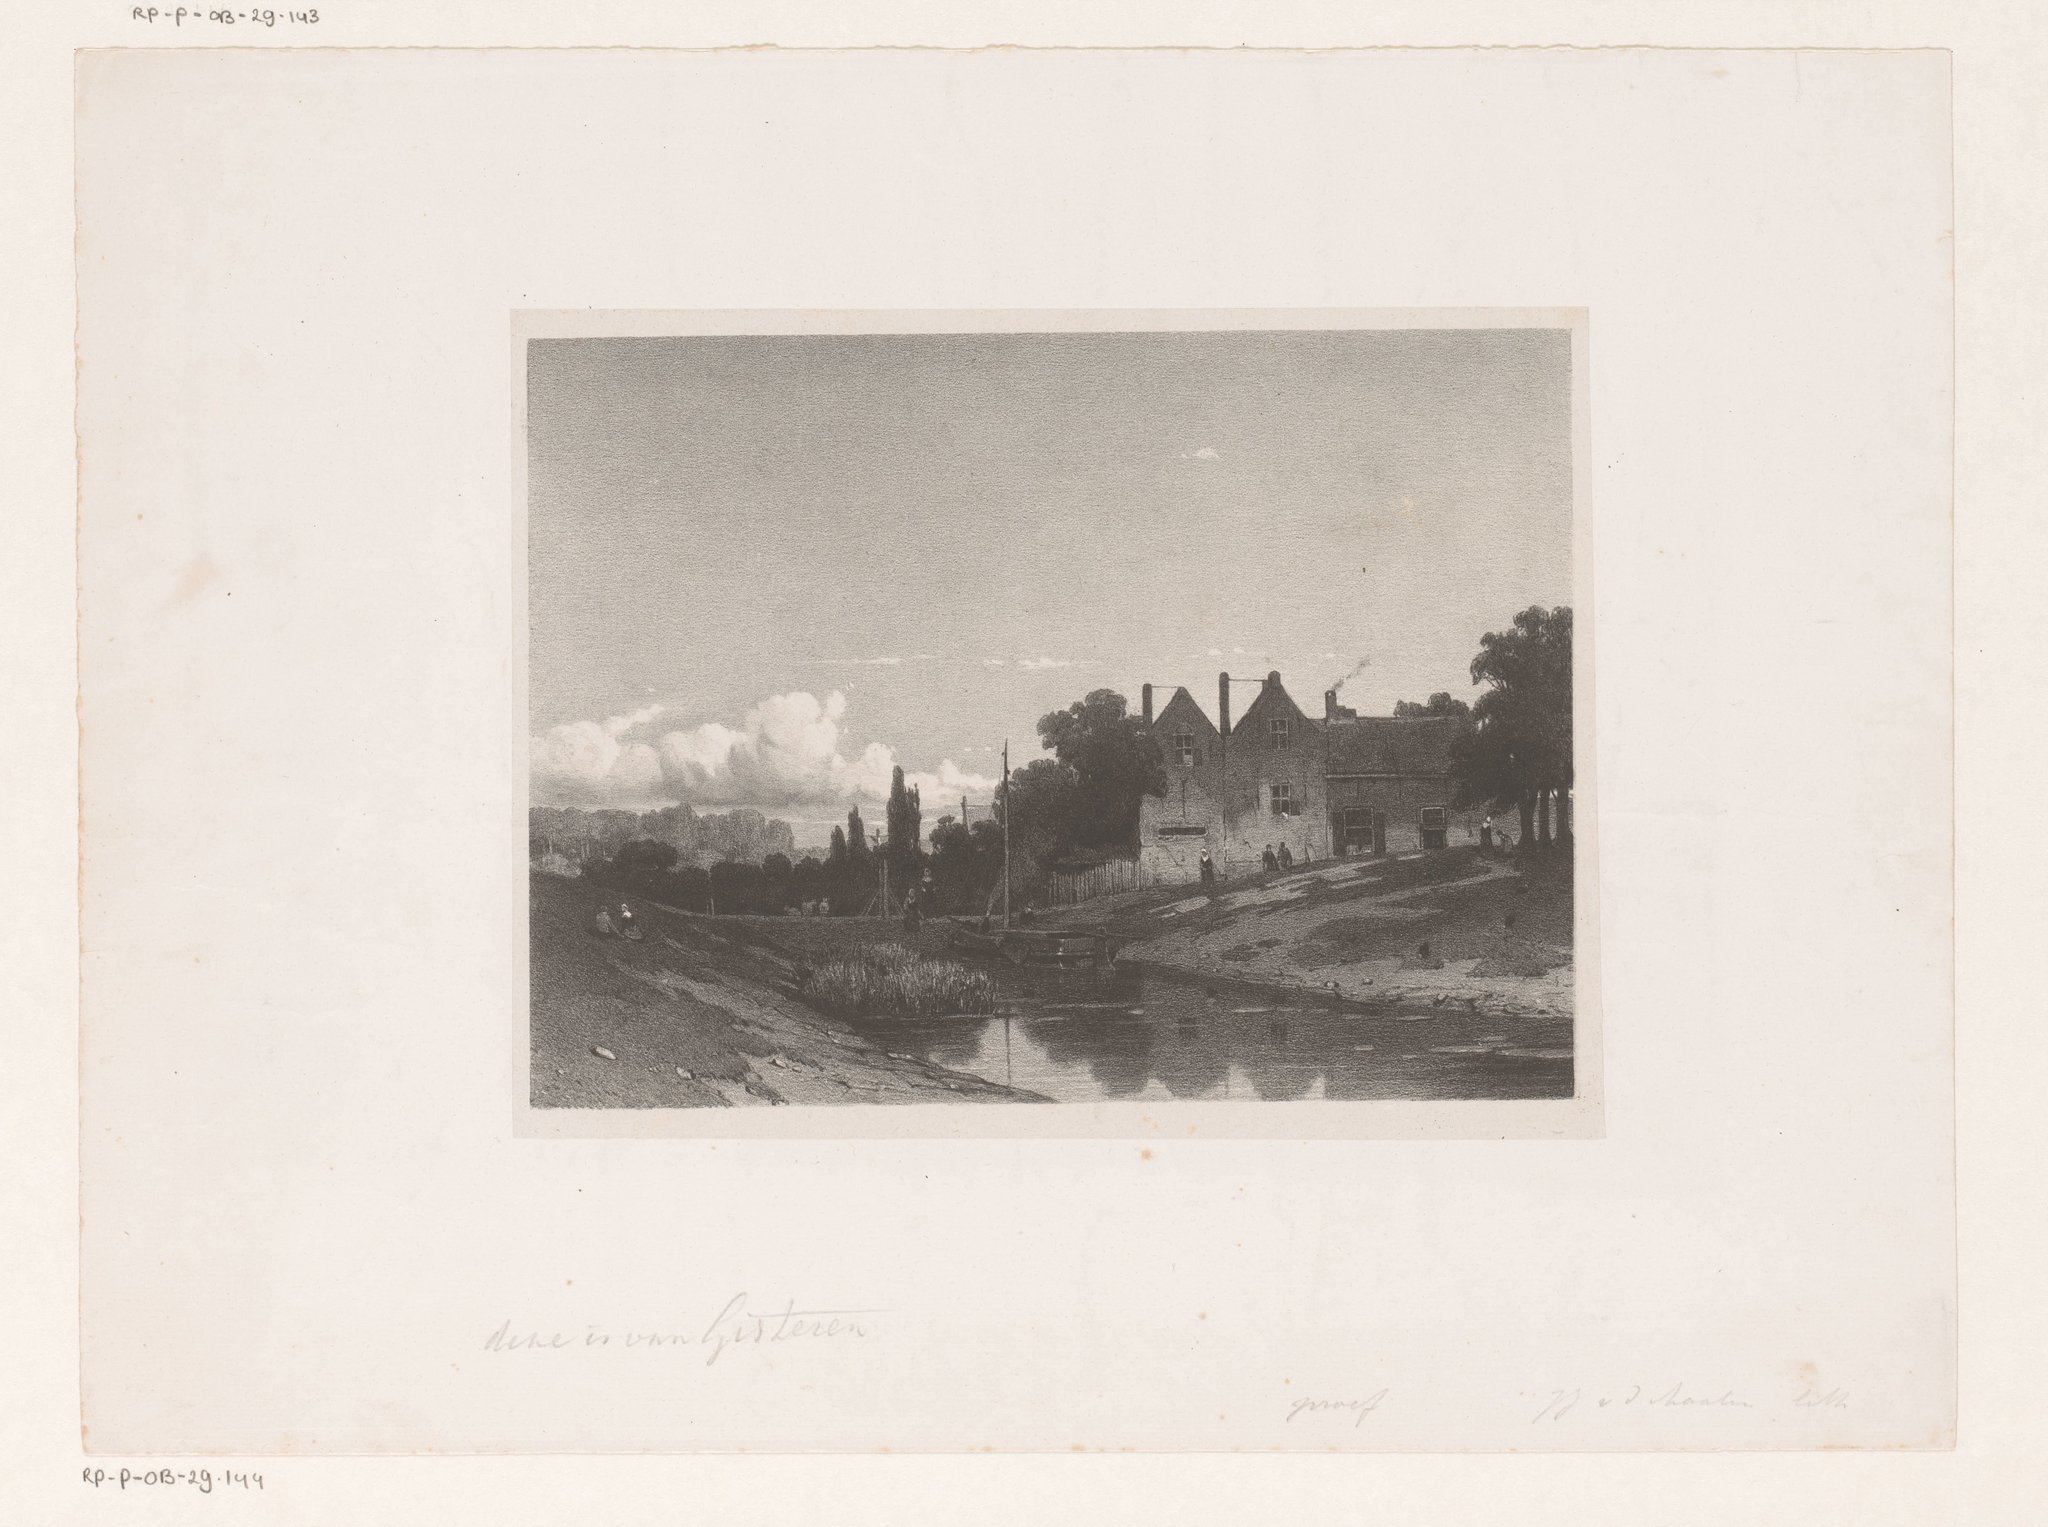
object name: print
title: Landschap met rivier, huizen en figuren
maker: jacob jan van der maaten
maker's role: draughtsman, print maker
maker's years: 1820-1879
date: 1843-1879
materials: paper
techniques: lithograph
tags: sailing-ship, sailing-boat, rural housing, e.g. country-house, villa, cottage, river (+ landscape with figures, staffage)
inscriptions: collector's mark: Lugt 2228, inscription: ‘deze is van gisteren / groot J J v d Maaten lith’